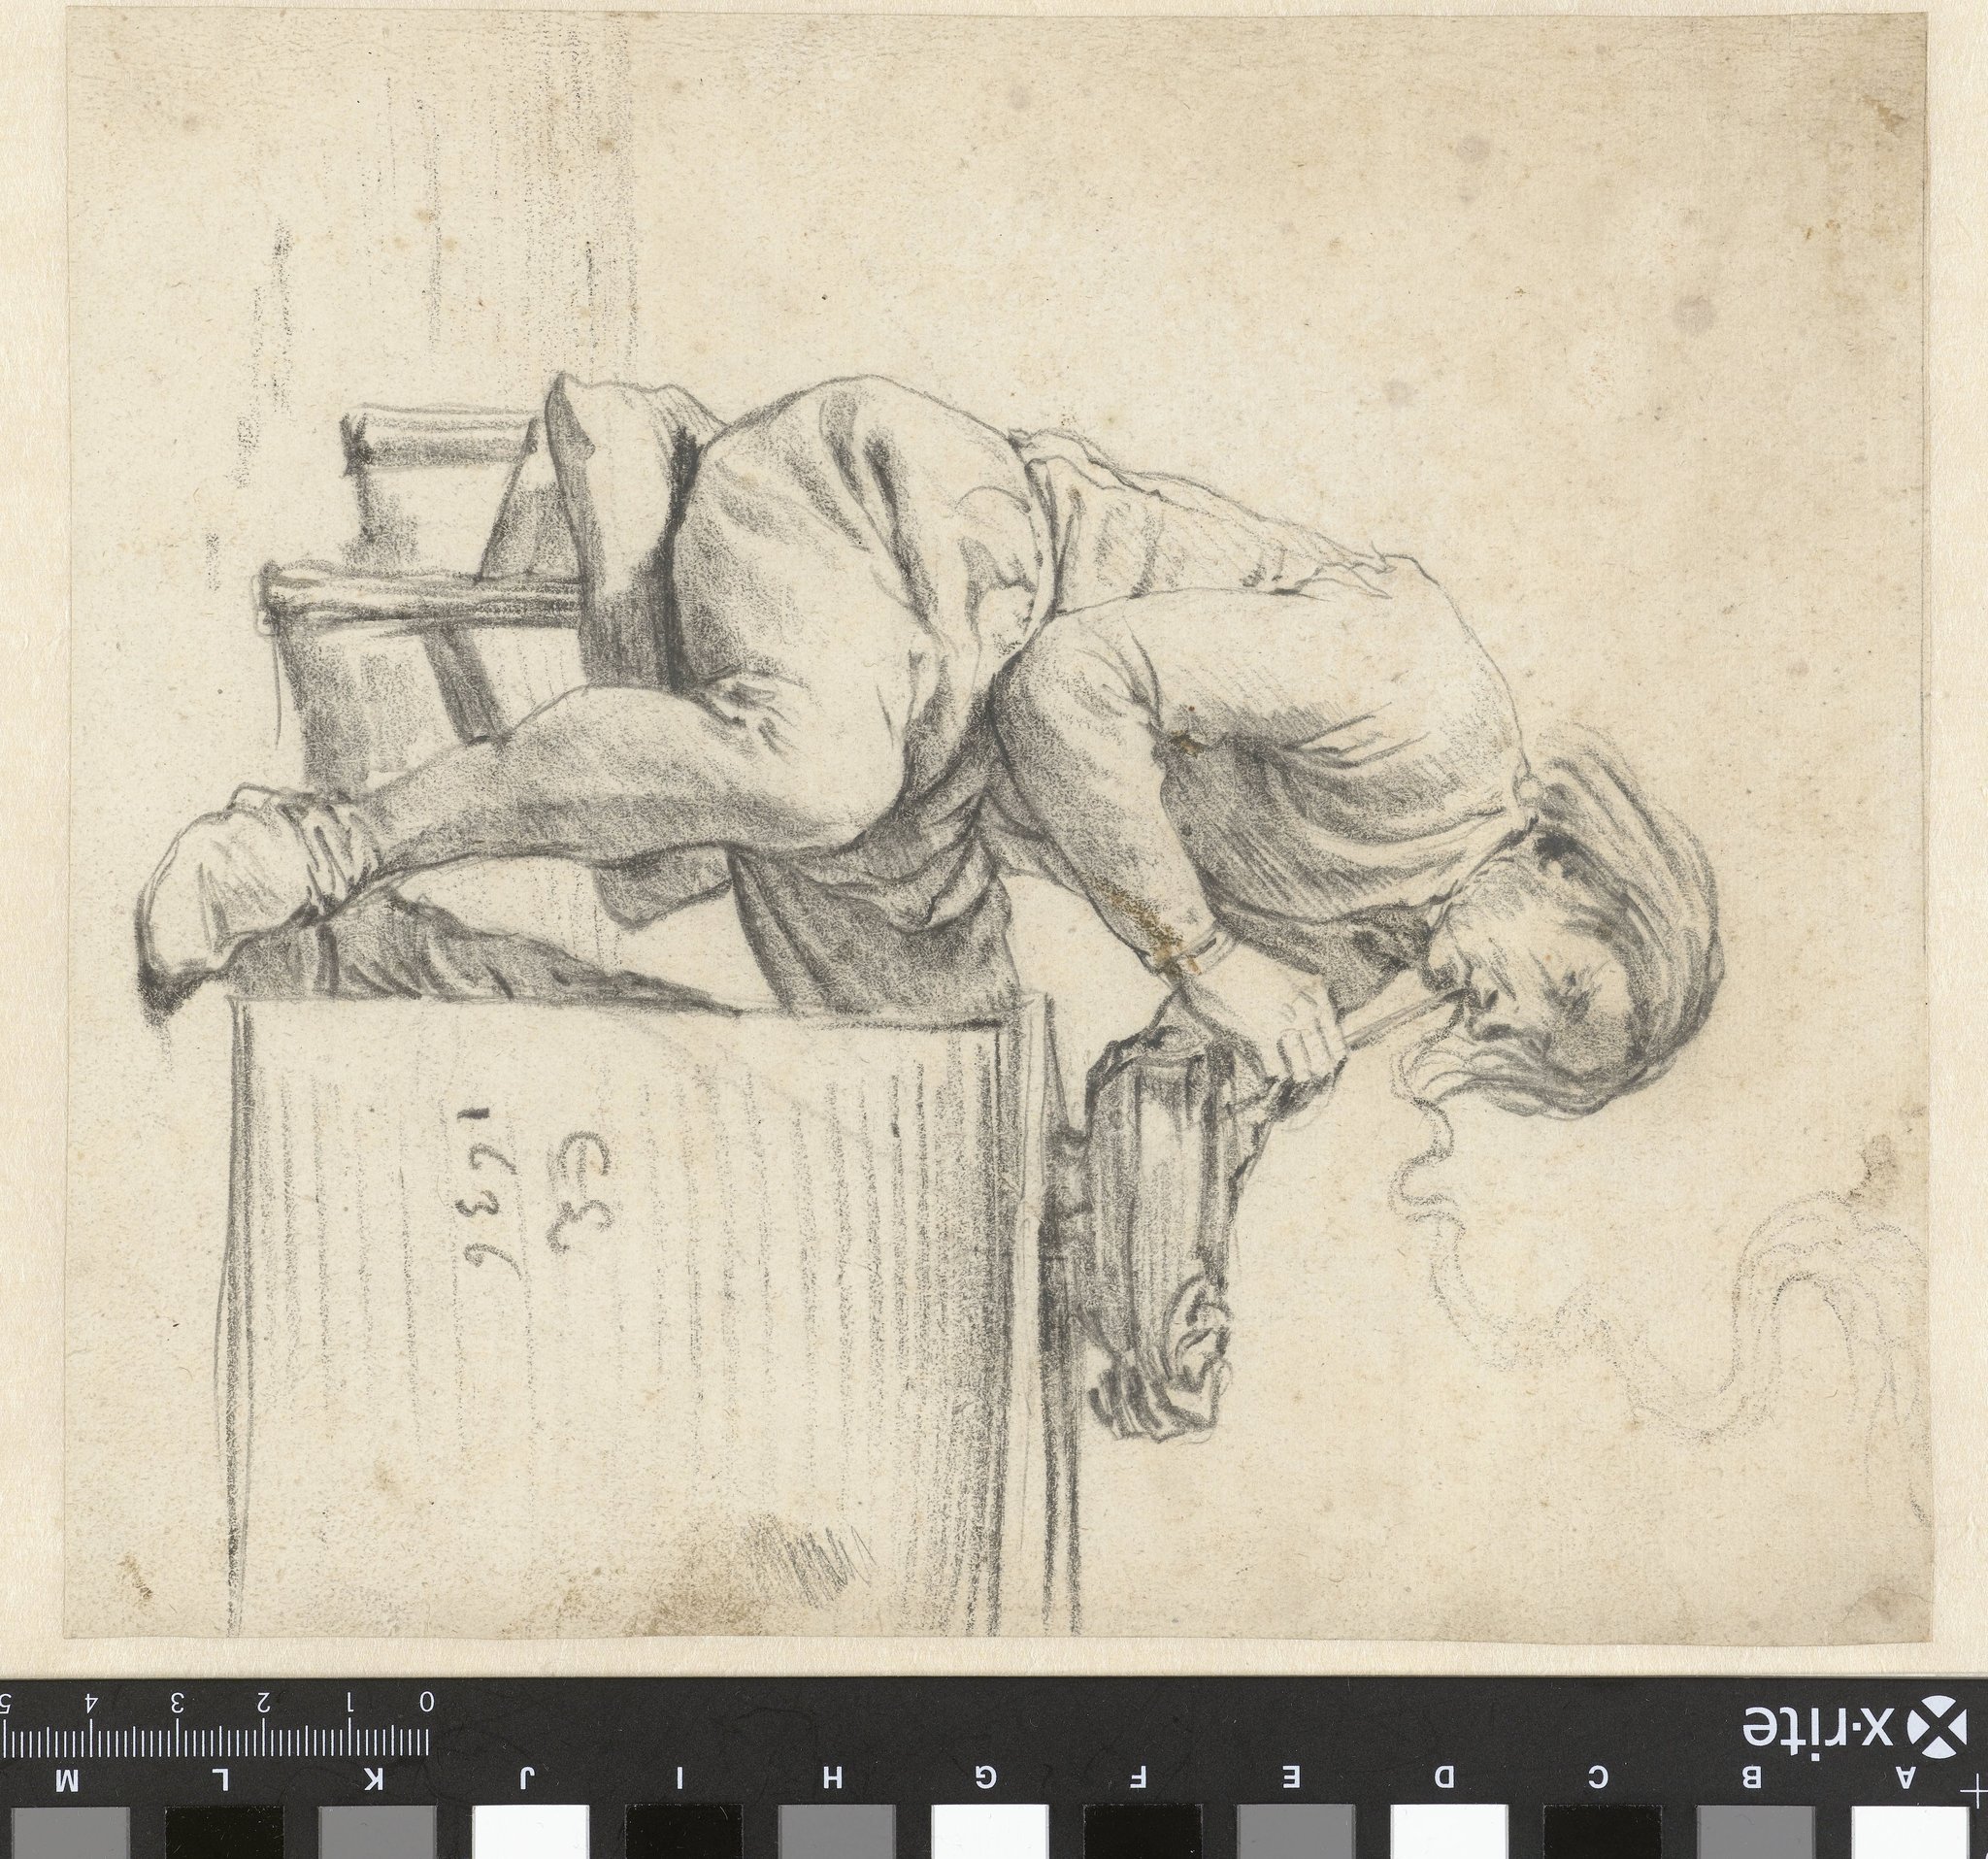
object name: drawing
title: Seated Man Smoking, with a Coal Pan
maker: cornelis saftleven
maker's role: draughtsman, painter, print maker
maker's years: 1607-1681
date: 1636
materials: chalk, graphite, paper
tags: sitting figure, pipe ~ tobacco (+ taking (particular) foodstuffs: eating, drinking, smoking, chewing, etc.)